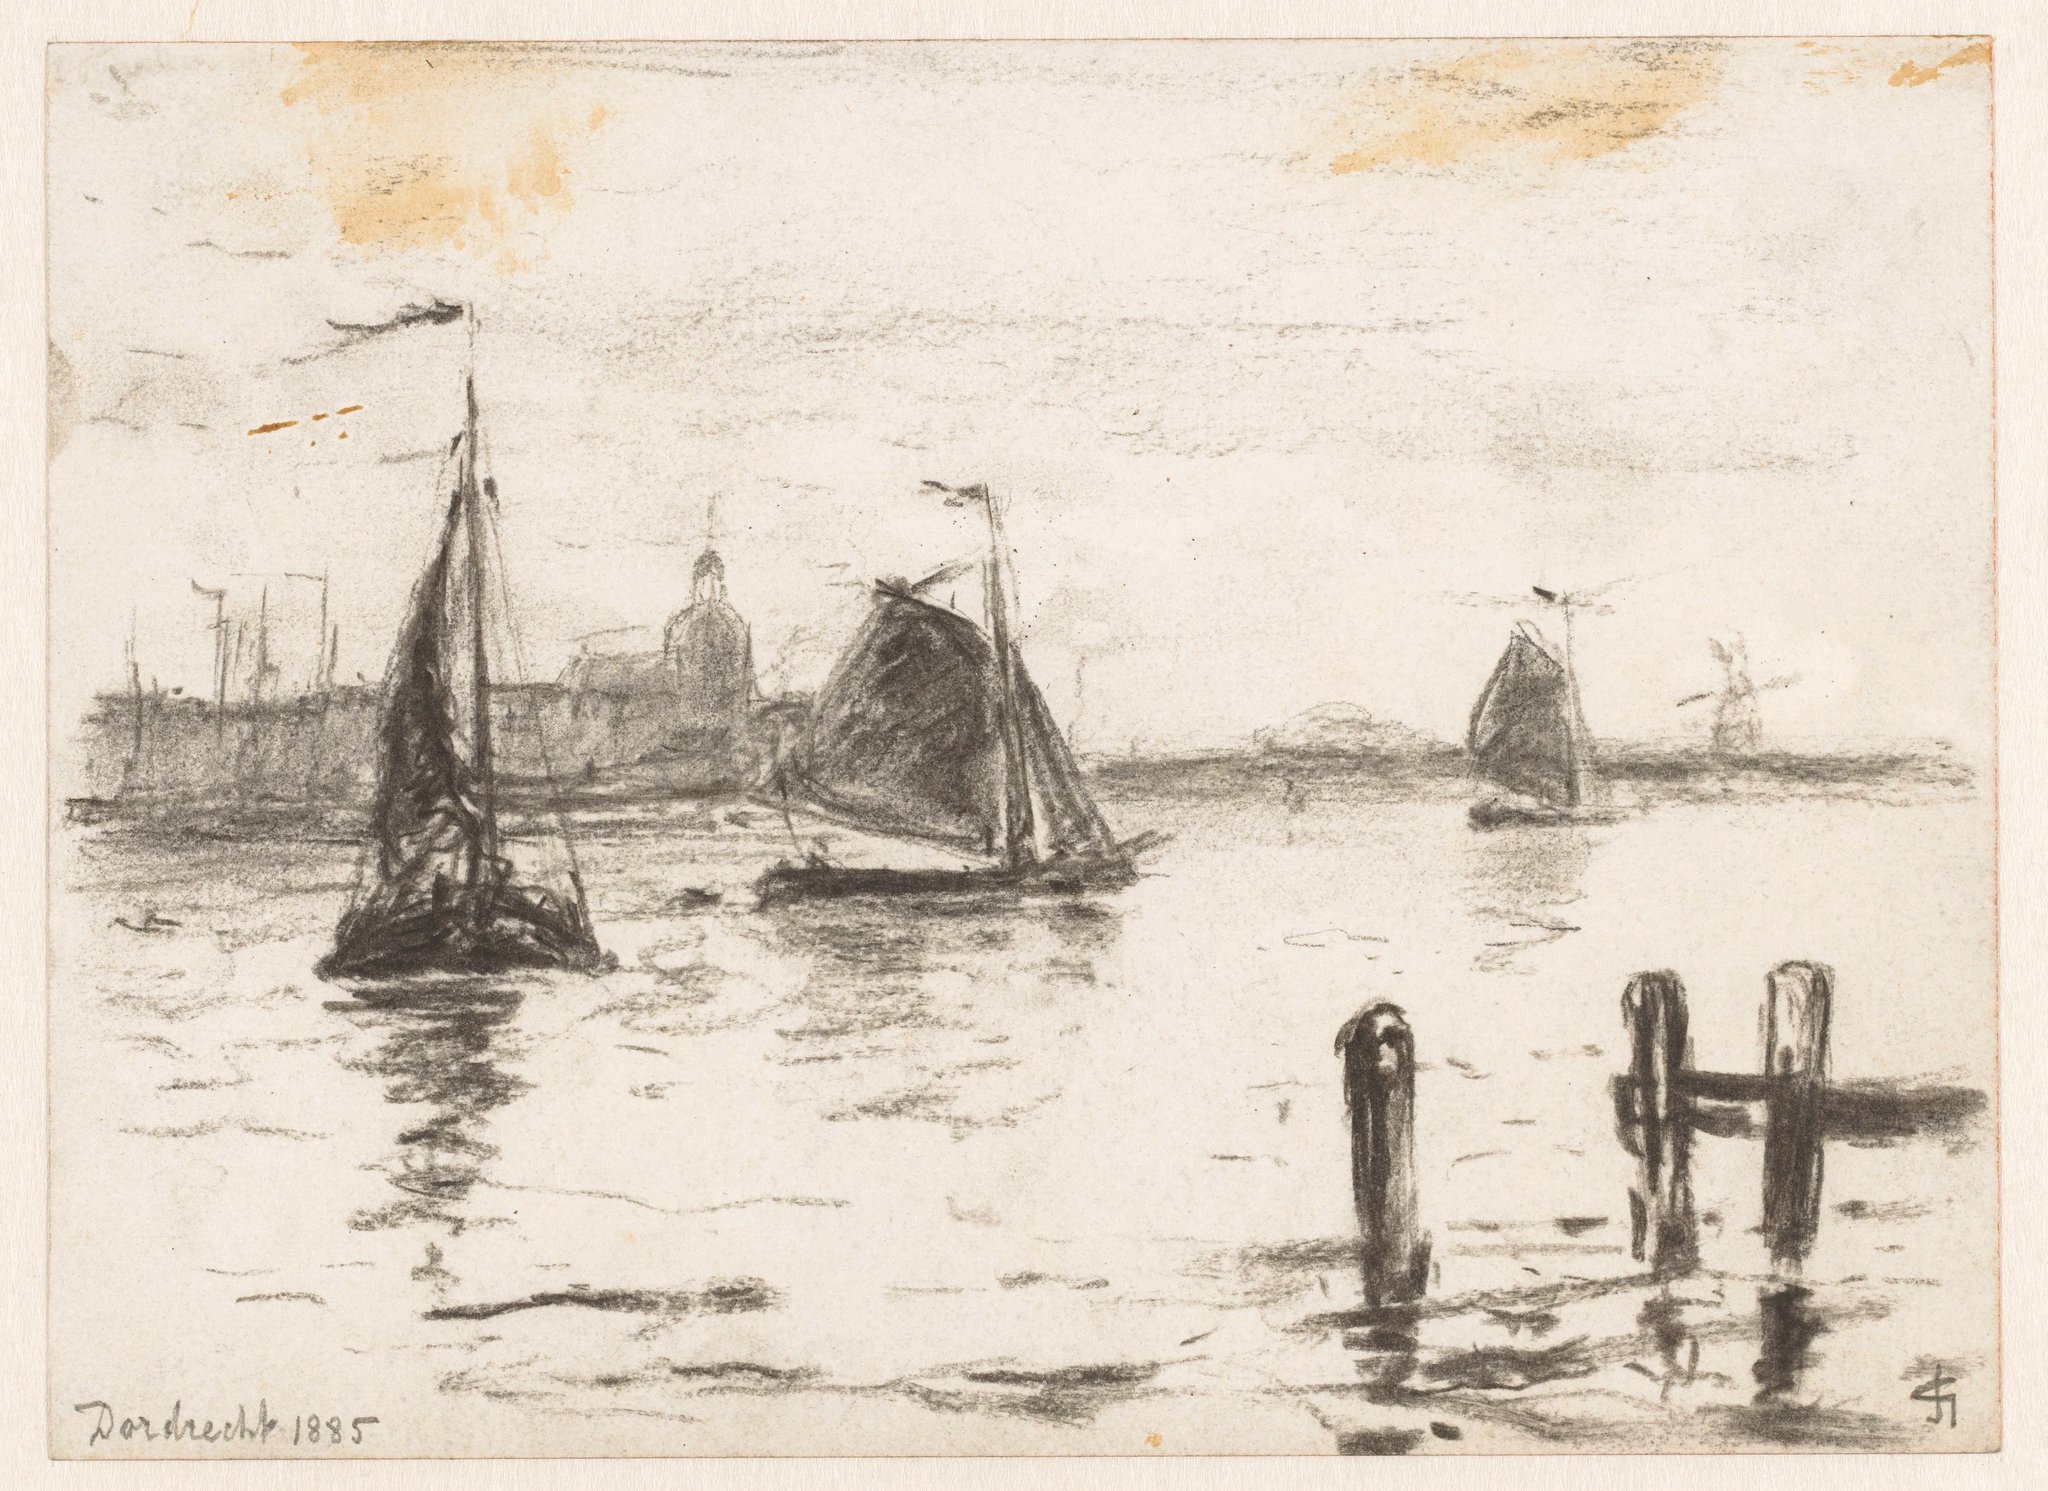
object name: drawing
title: Vissersschepen op de Maas voor Dordrecht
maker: carel nicolaas storm van s-gravesande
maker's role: draughtsman, print maker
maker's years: 1841-1924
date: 1885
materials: charcoal, paper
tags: sailing-ship, sailing-boat, dordrecht